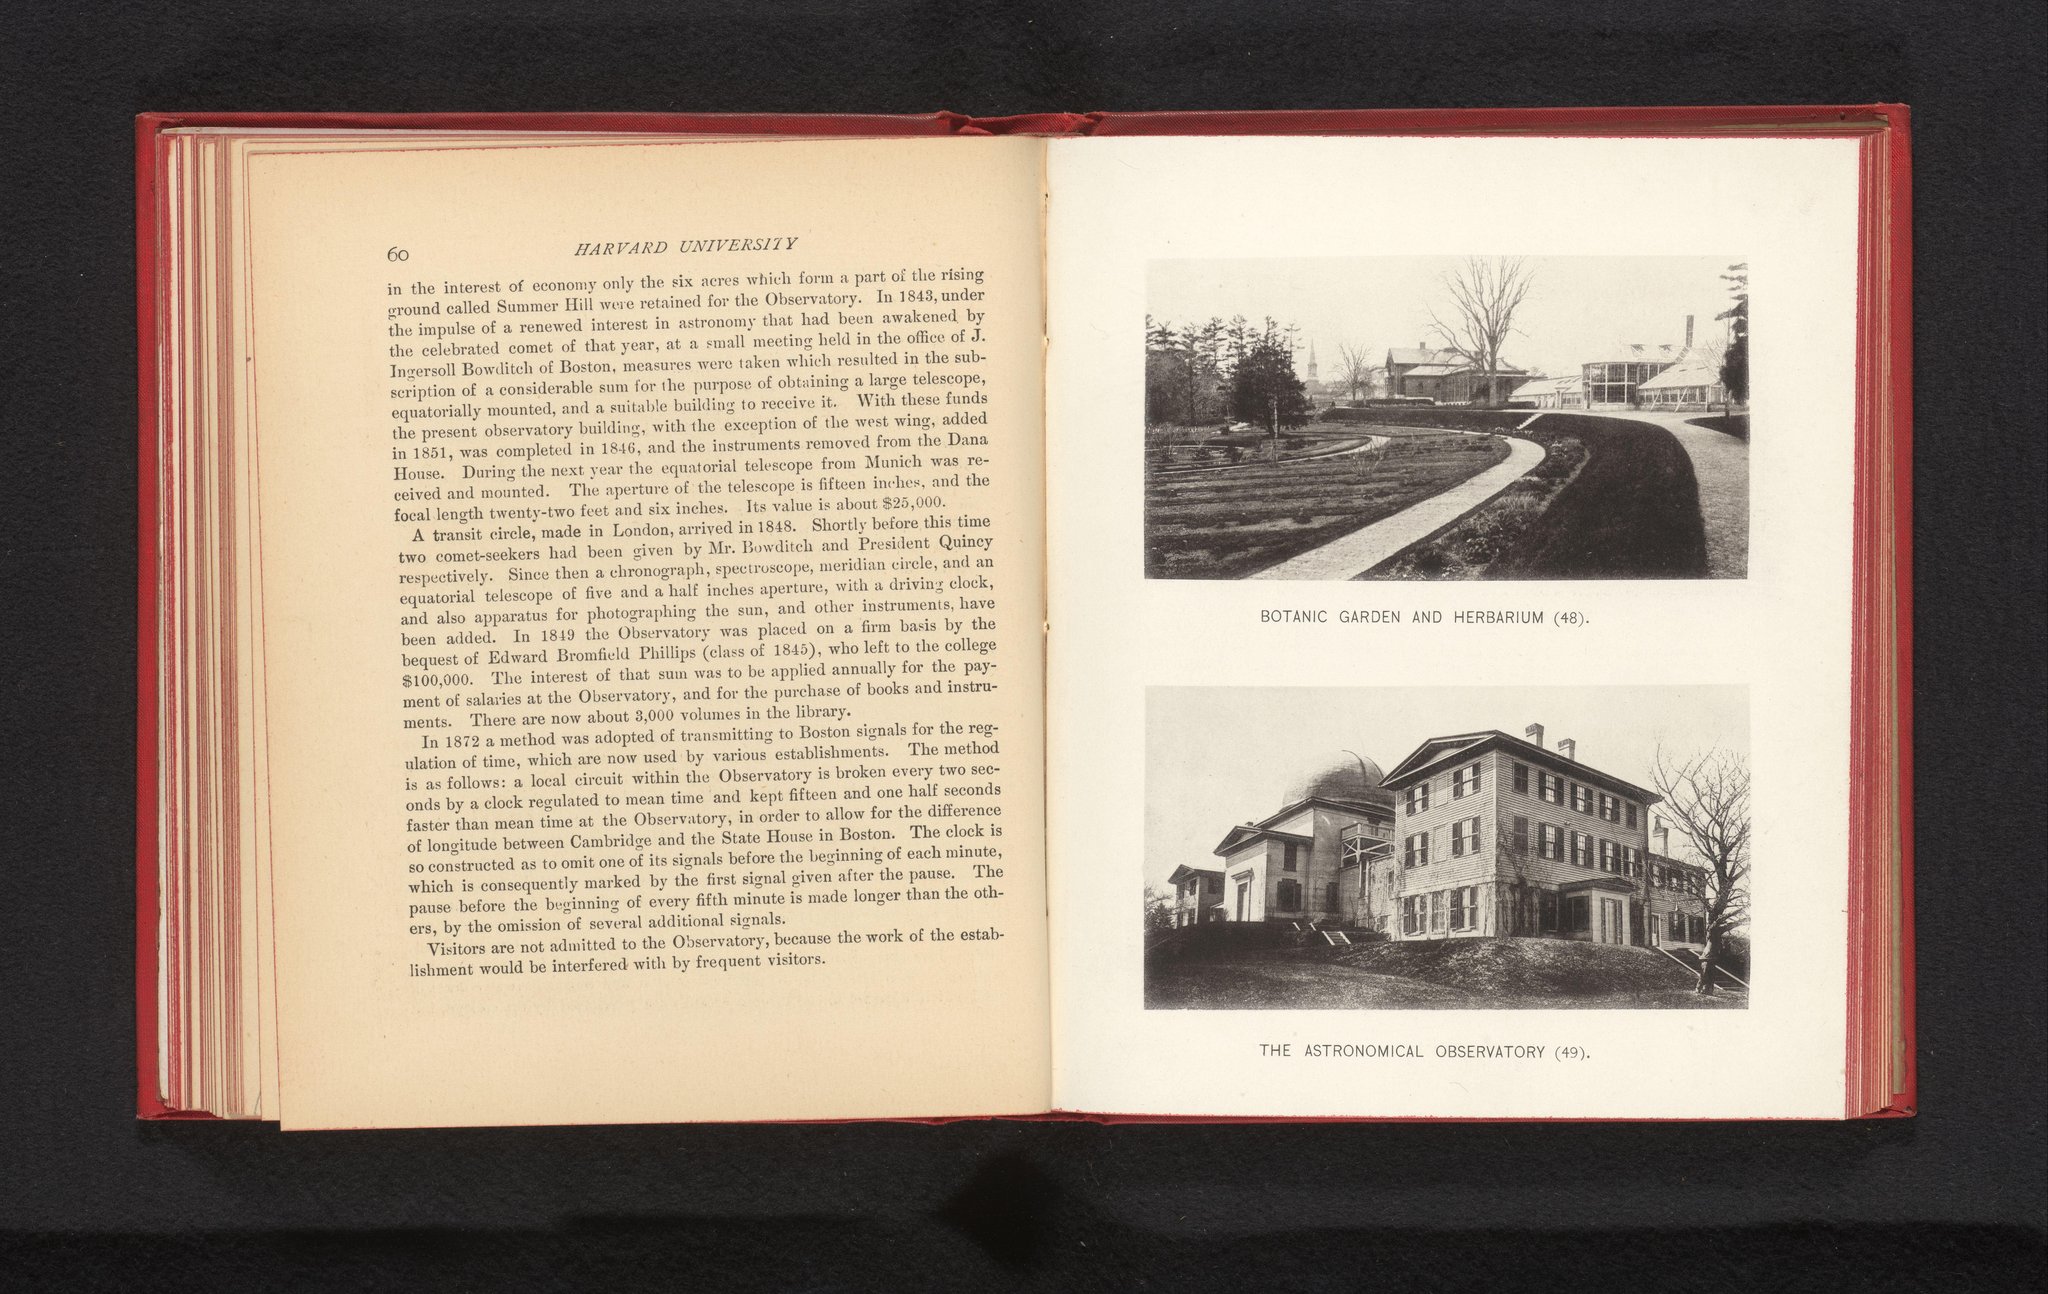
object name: page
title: The astronomical observatory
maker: Anonymous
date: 1881-1886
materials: paper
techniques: photograph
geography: cambridge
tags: observatory (~ astronomy), botanic garden, 'hortus botanicus', façade (of house or building)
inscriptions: number: ‘(48) (49)’